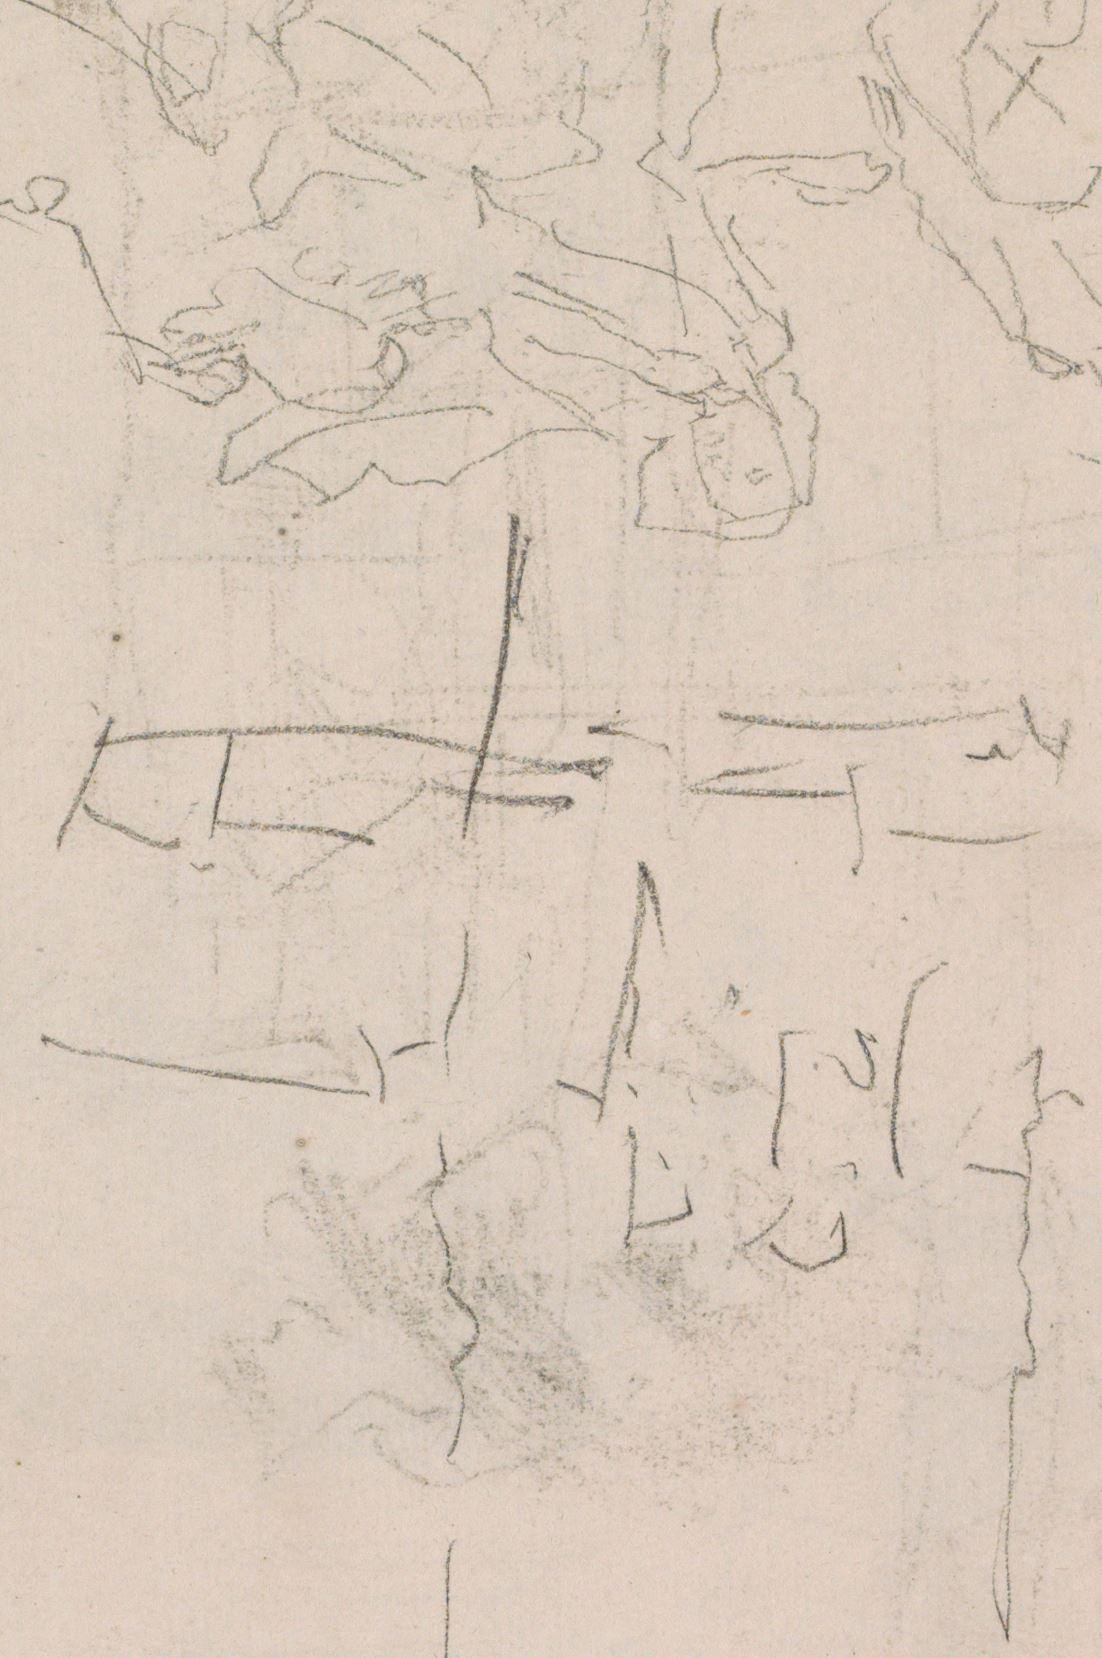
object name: sketchbook leaf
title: Figuurstudies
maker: george hendrik breitner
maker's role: draughtsman, painter, print maker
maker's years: 1857-1923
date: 1880-1882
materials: chalk, paper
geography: the hague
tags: adult woman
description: Pagina 22 uit een schetsboek met 29 bladen.